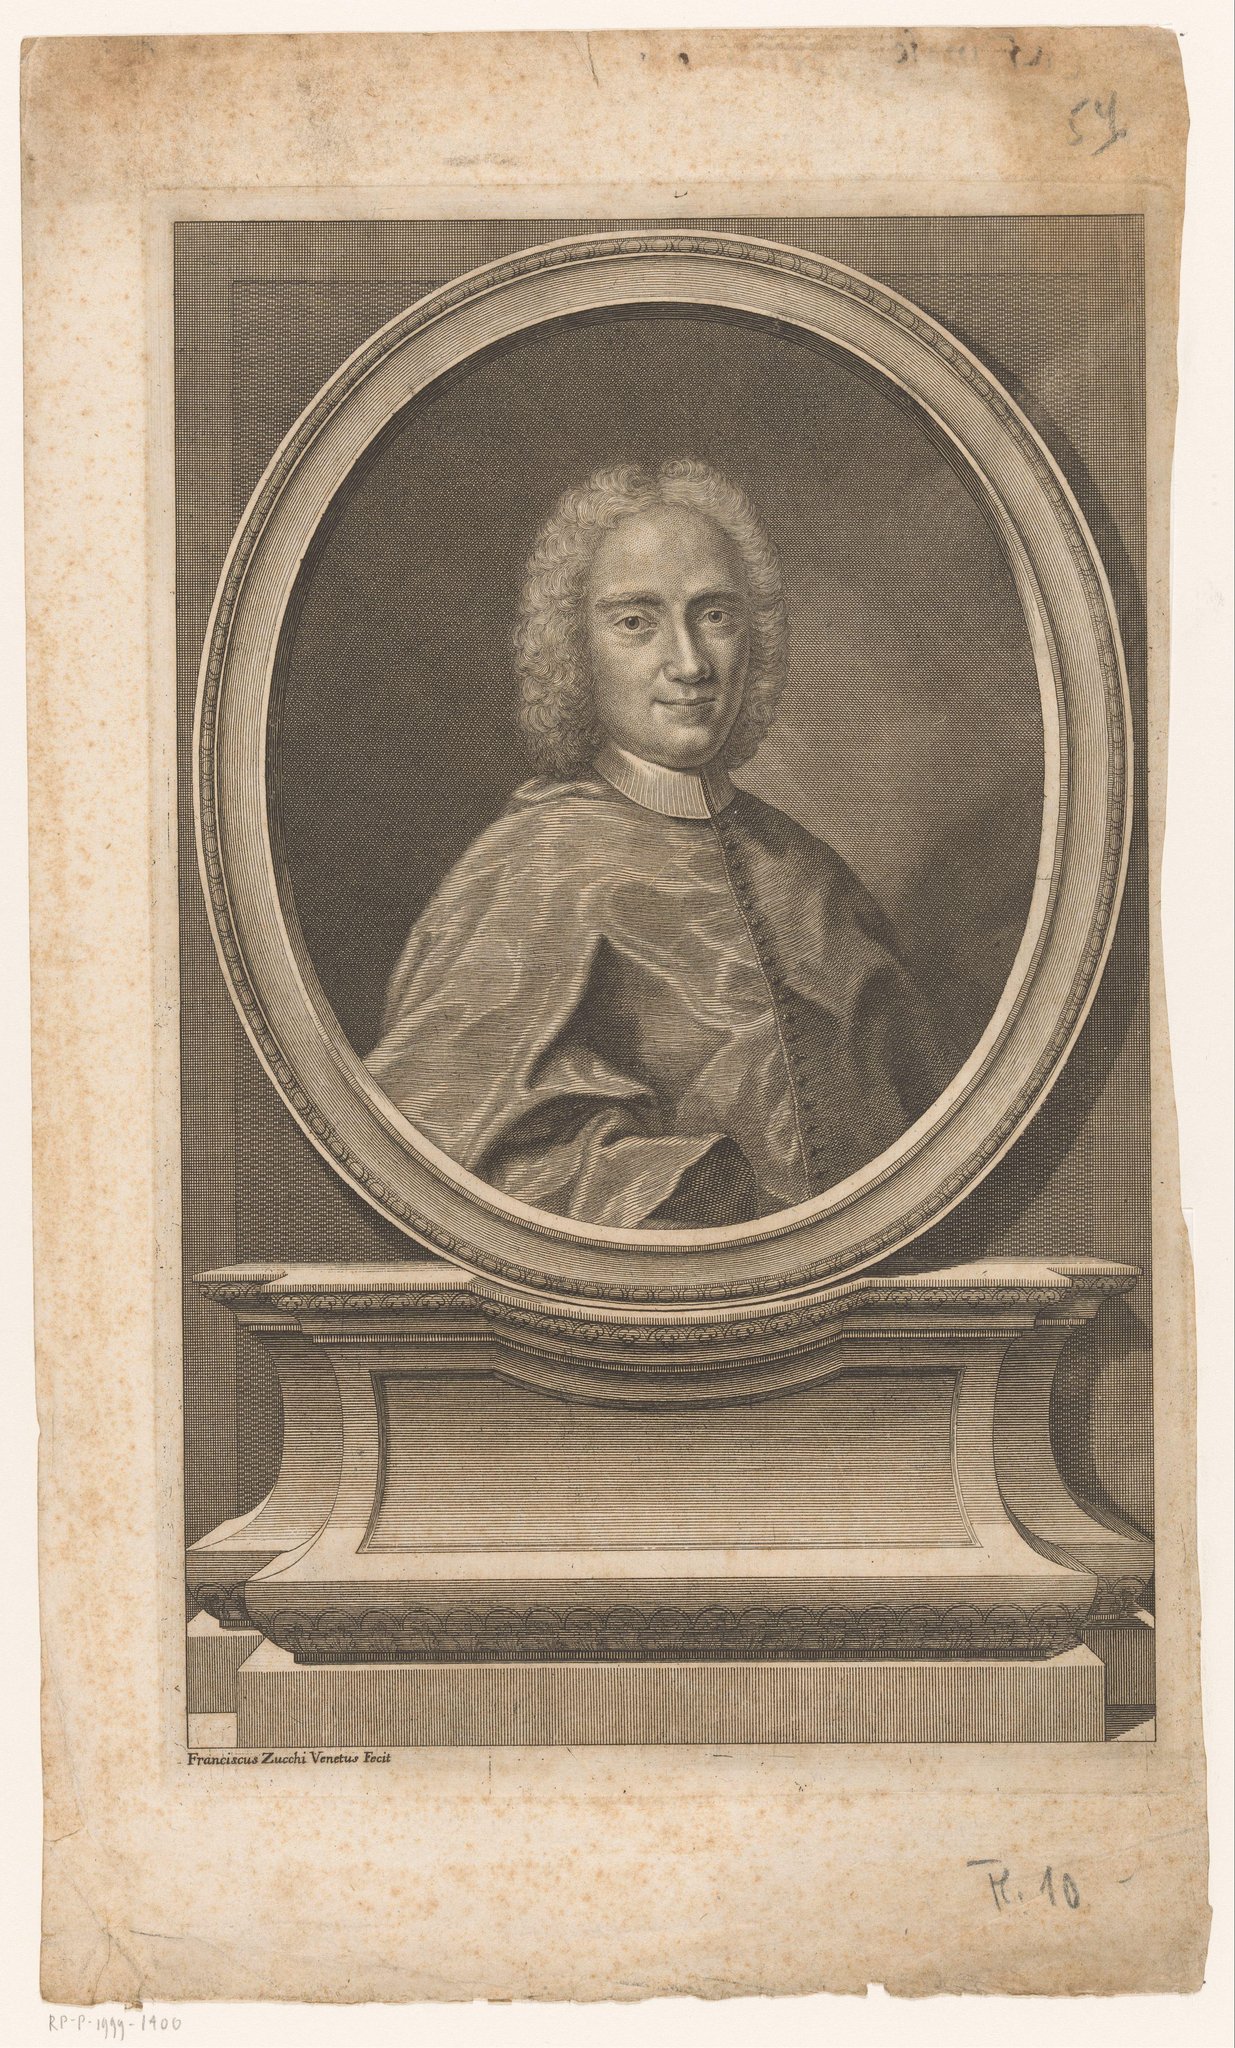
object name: print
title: Portret van kardinaal Cornelio Bentivoglio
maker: francesco zucchi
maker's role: print maker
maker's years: 1692-1764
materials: paper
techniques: engraving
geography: venice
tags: rome, cardinal, historical persons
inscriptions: collector's mark: Lugt 2228, inscription: ‘Cardinale Bentivolo’, collector's mark: Lugt 2760